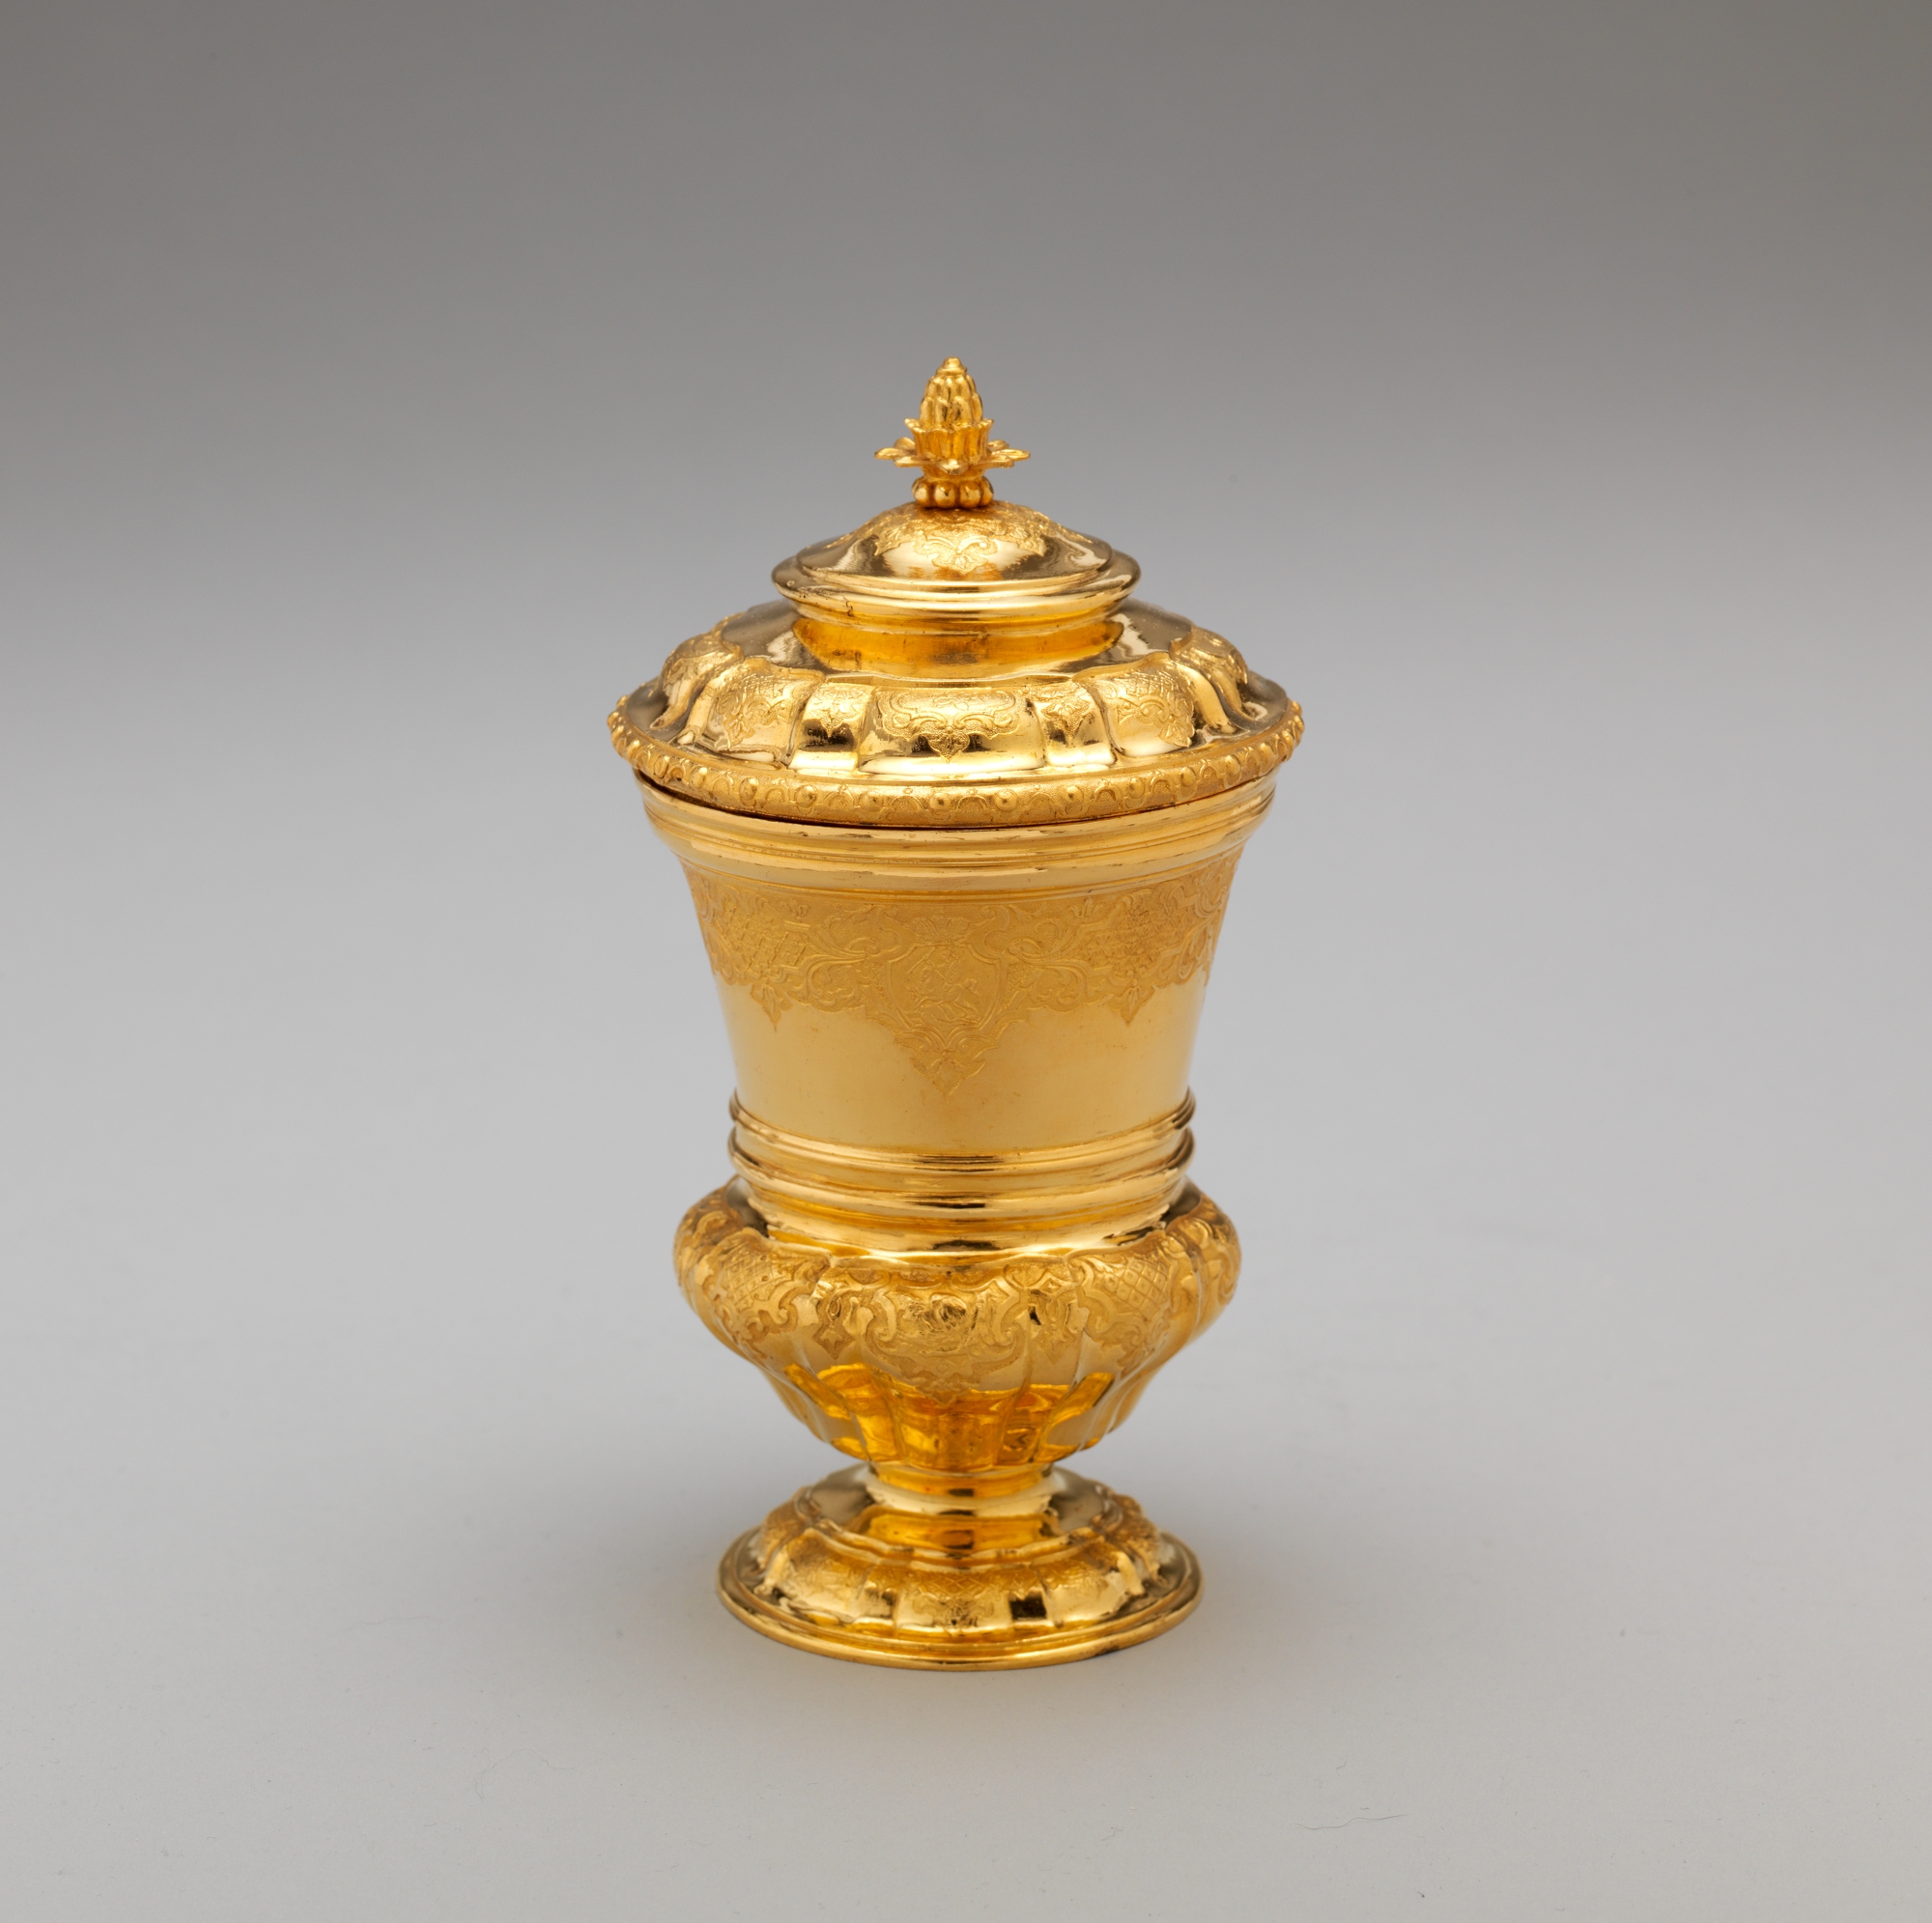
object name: cup with cover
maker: johann ludwig ii biller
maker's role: maker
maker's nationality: german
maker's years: 1692-1746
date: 1801-1900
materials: gold